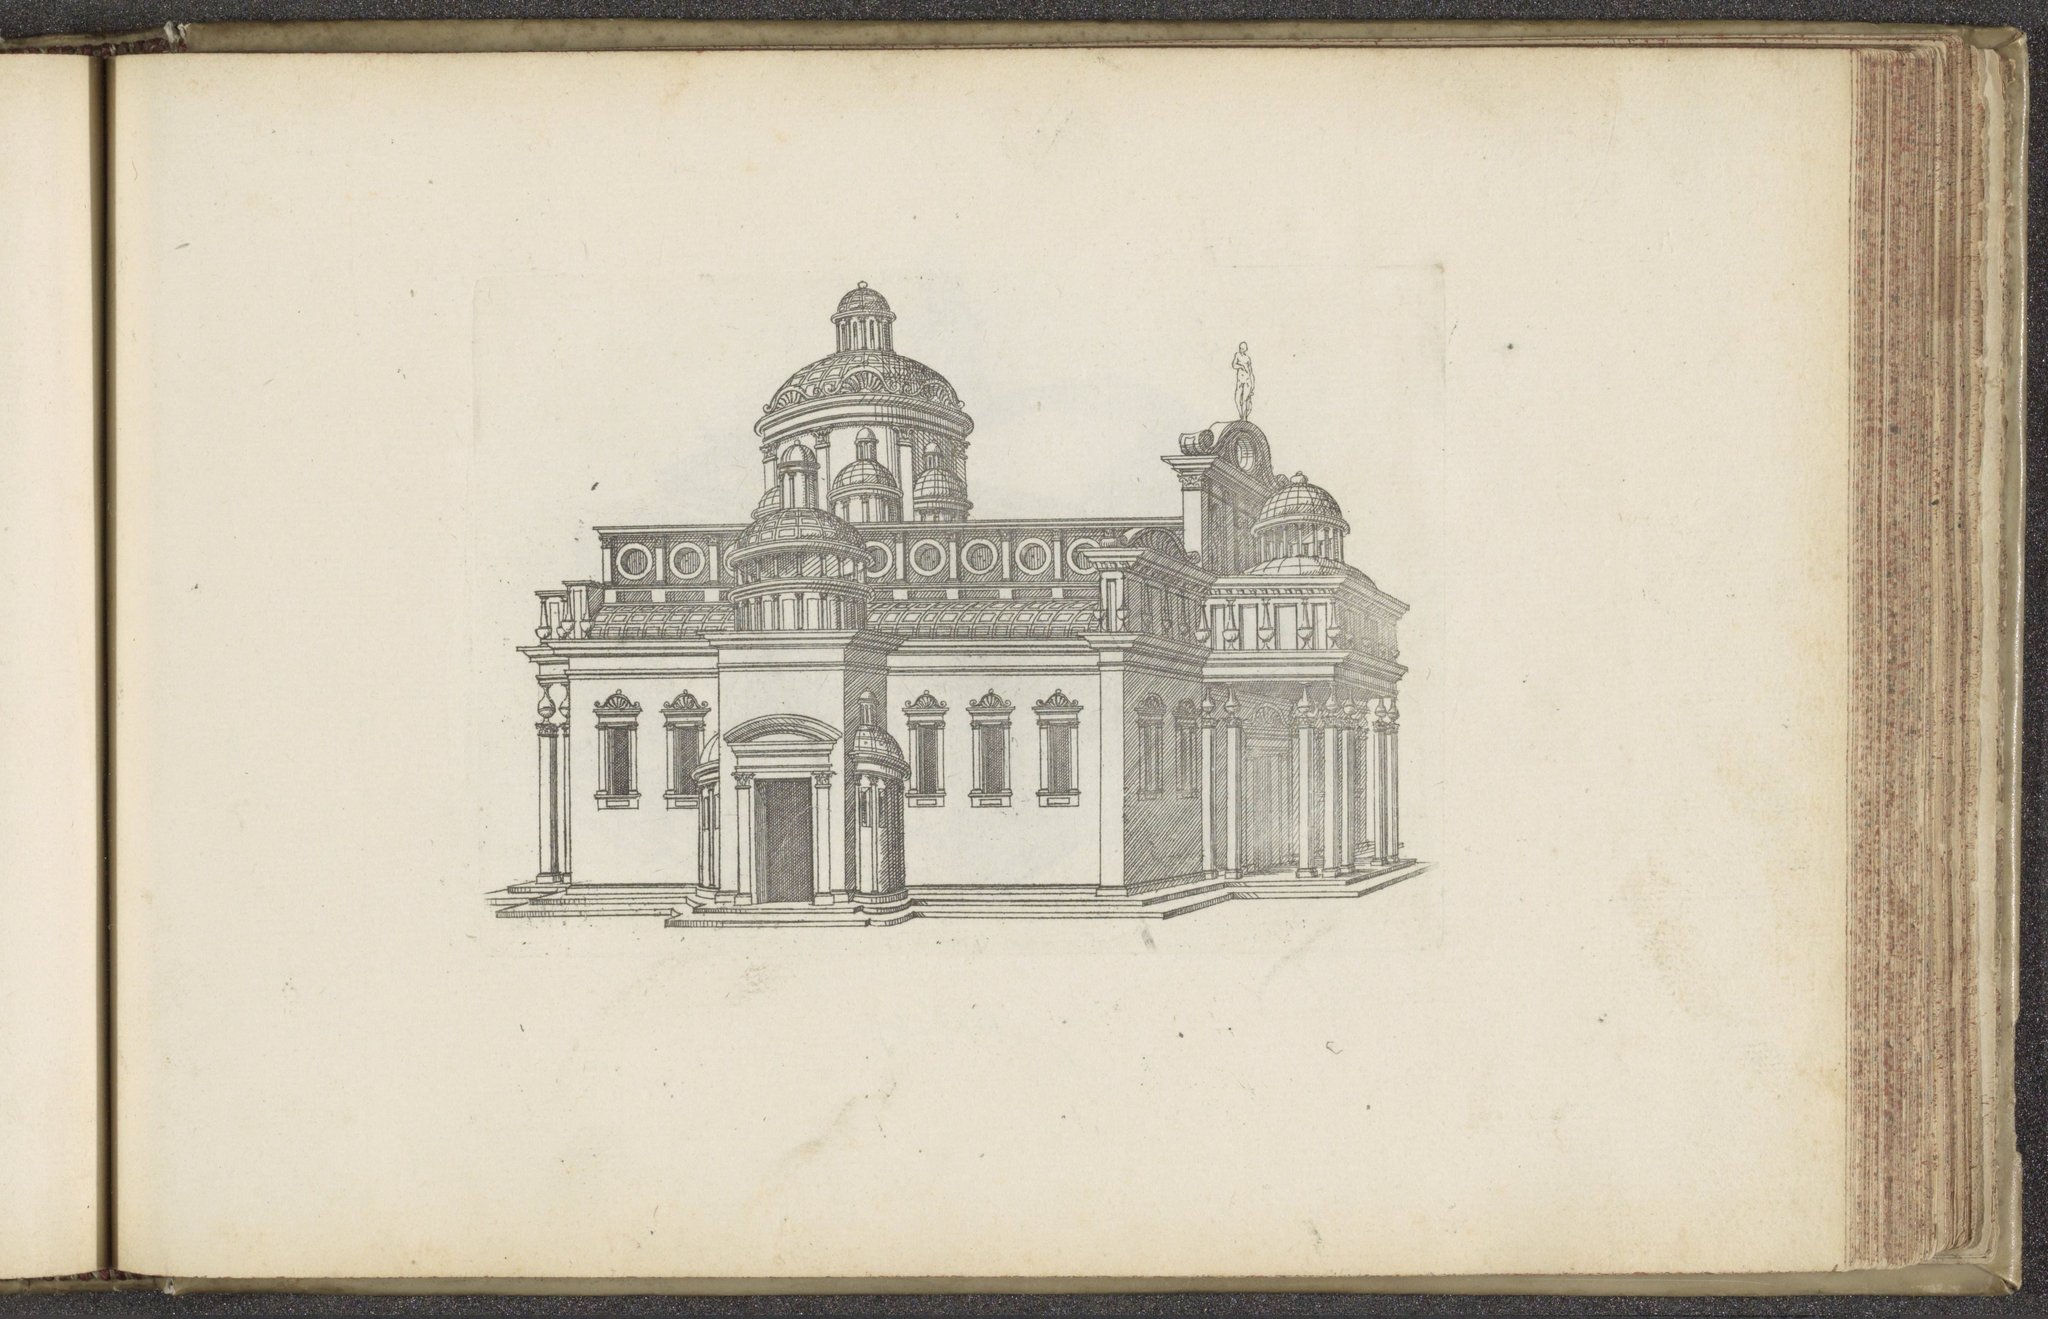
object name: album leaf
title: Heiligdom met rechts een zuilenportaal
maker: jacques androuet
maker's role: draughtsman, print maker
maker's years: 1515-1584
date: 1550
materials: paper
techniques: etching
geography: orléans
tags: exterior ~ representation of a building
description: Heiligdom met rechts een zuilenportaal. Aan de zijkant eveneens een toegang. Deze prent maakt deel uit van een album.